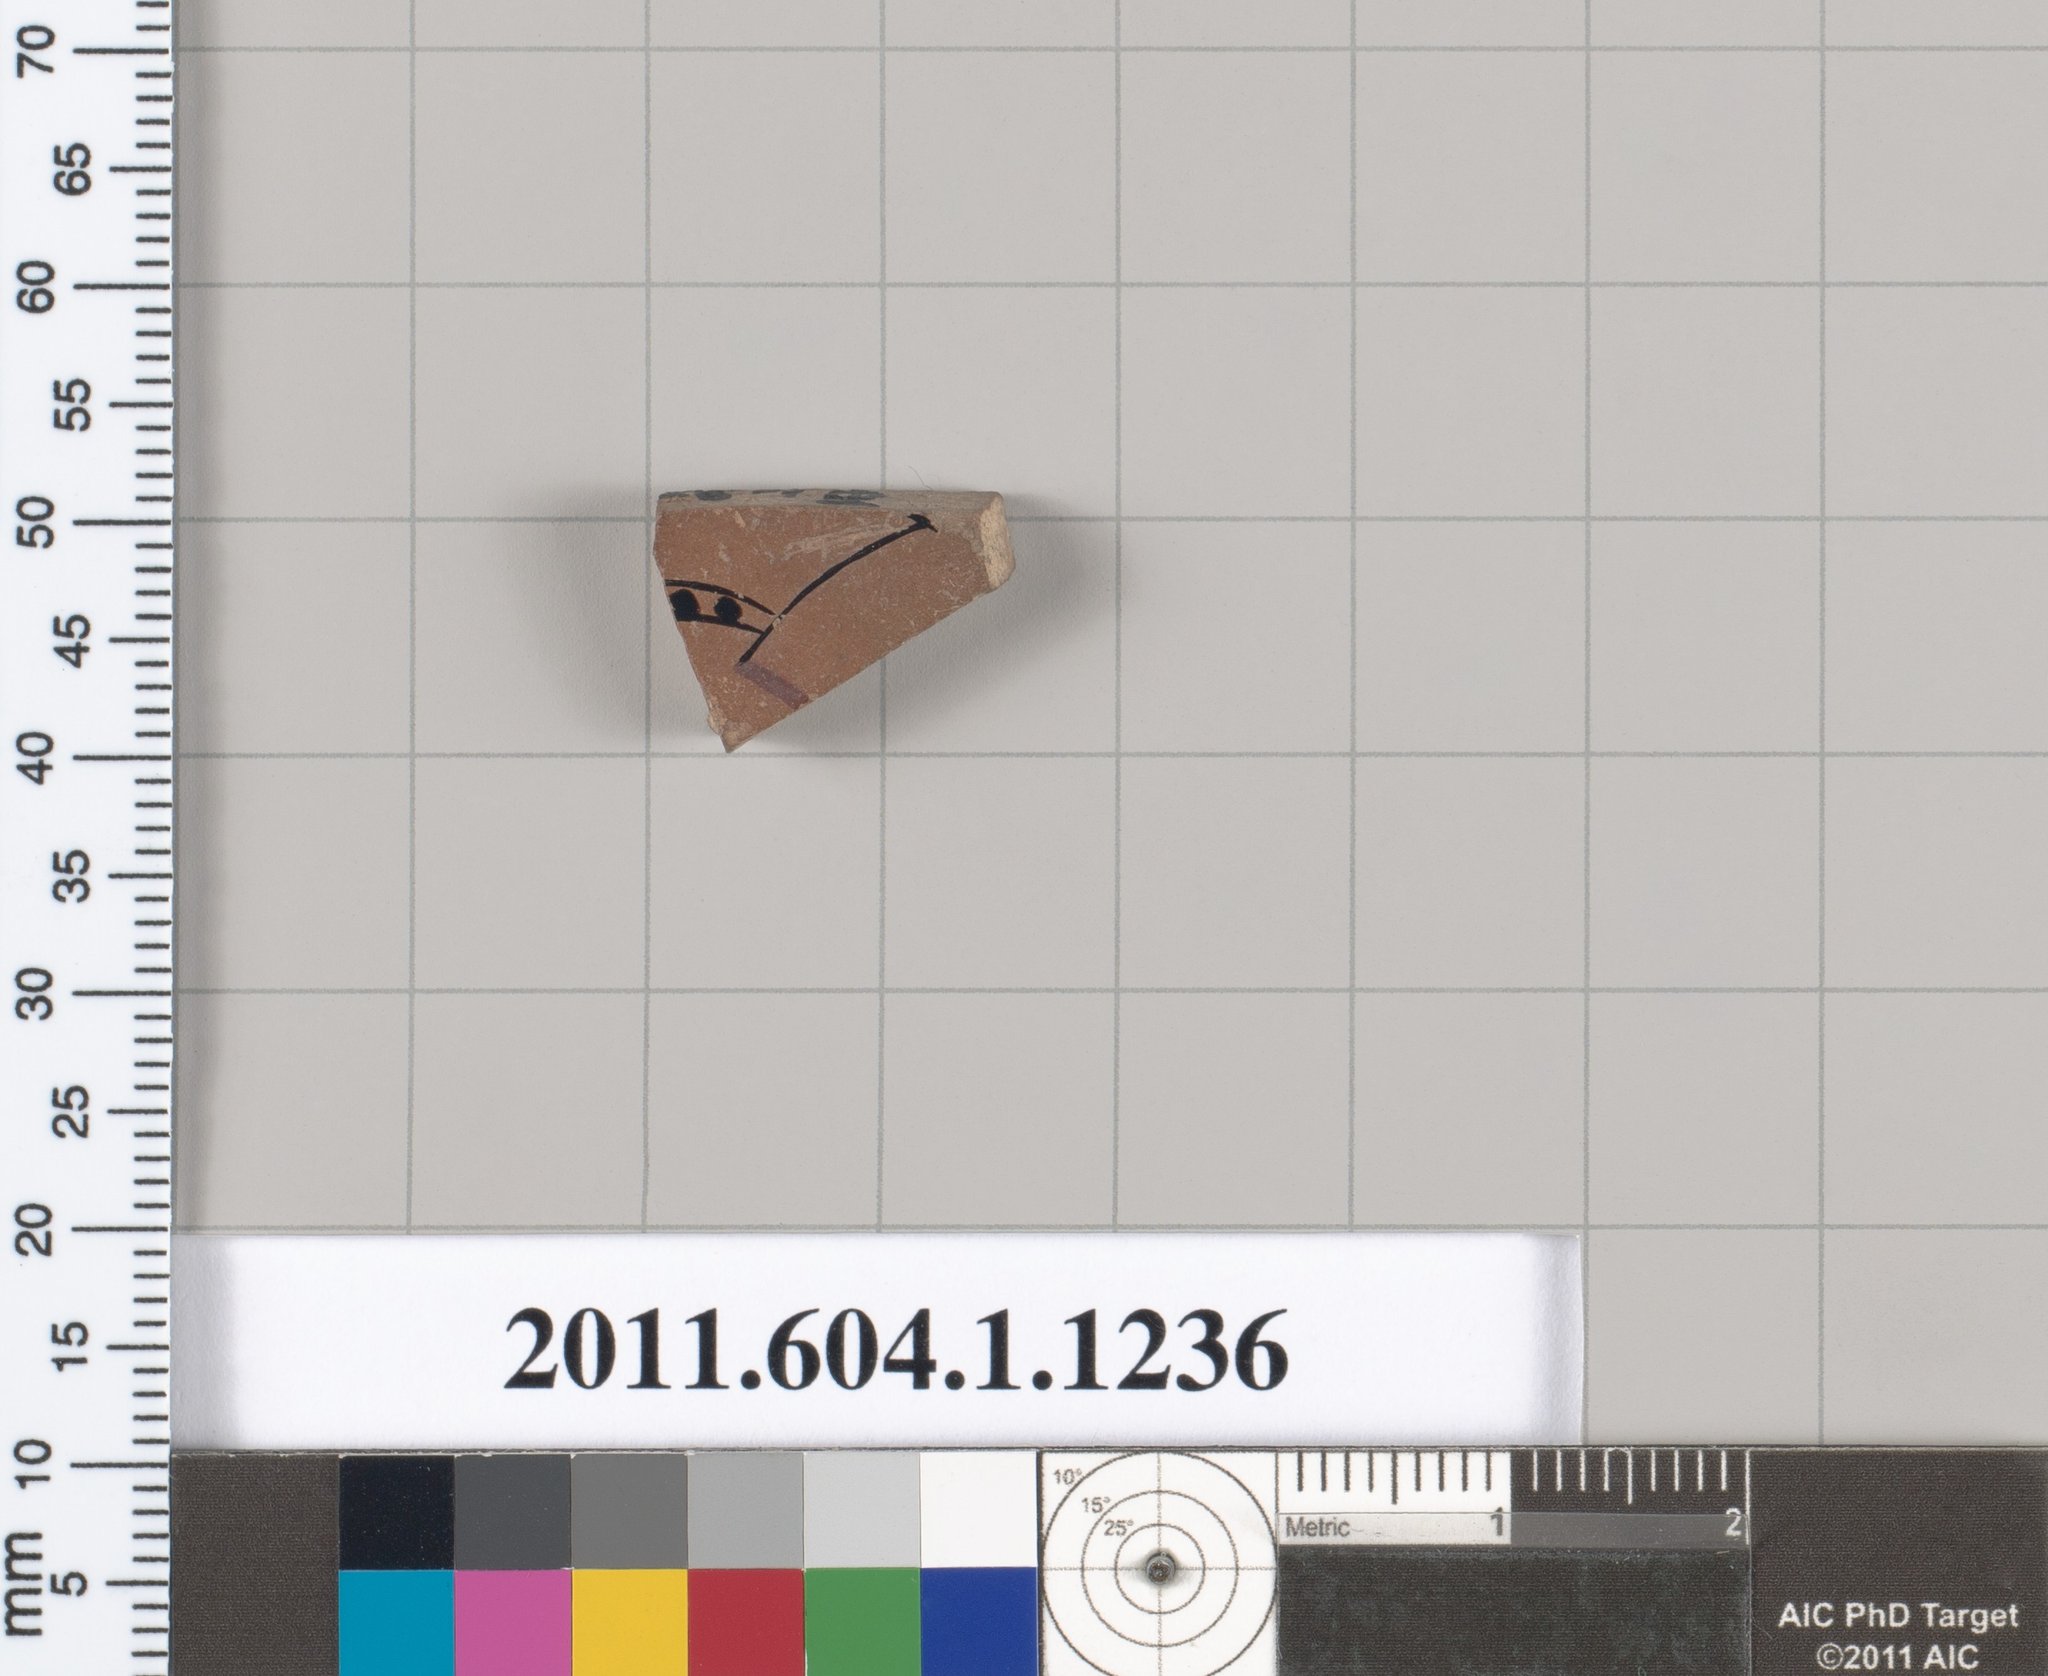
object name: kylix fragment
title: Terracotta fragment of a kylix (drinking cup)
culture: greek, attic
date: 500-480 BCE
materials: terracotta